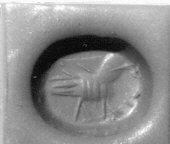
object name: stamp seal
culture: sasanian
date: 201-700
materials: stone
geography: iran or mesopotamia